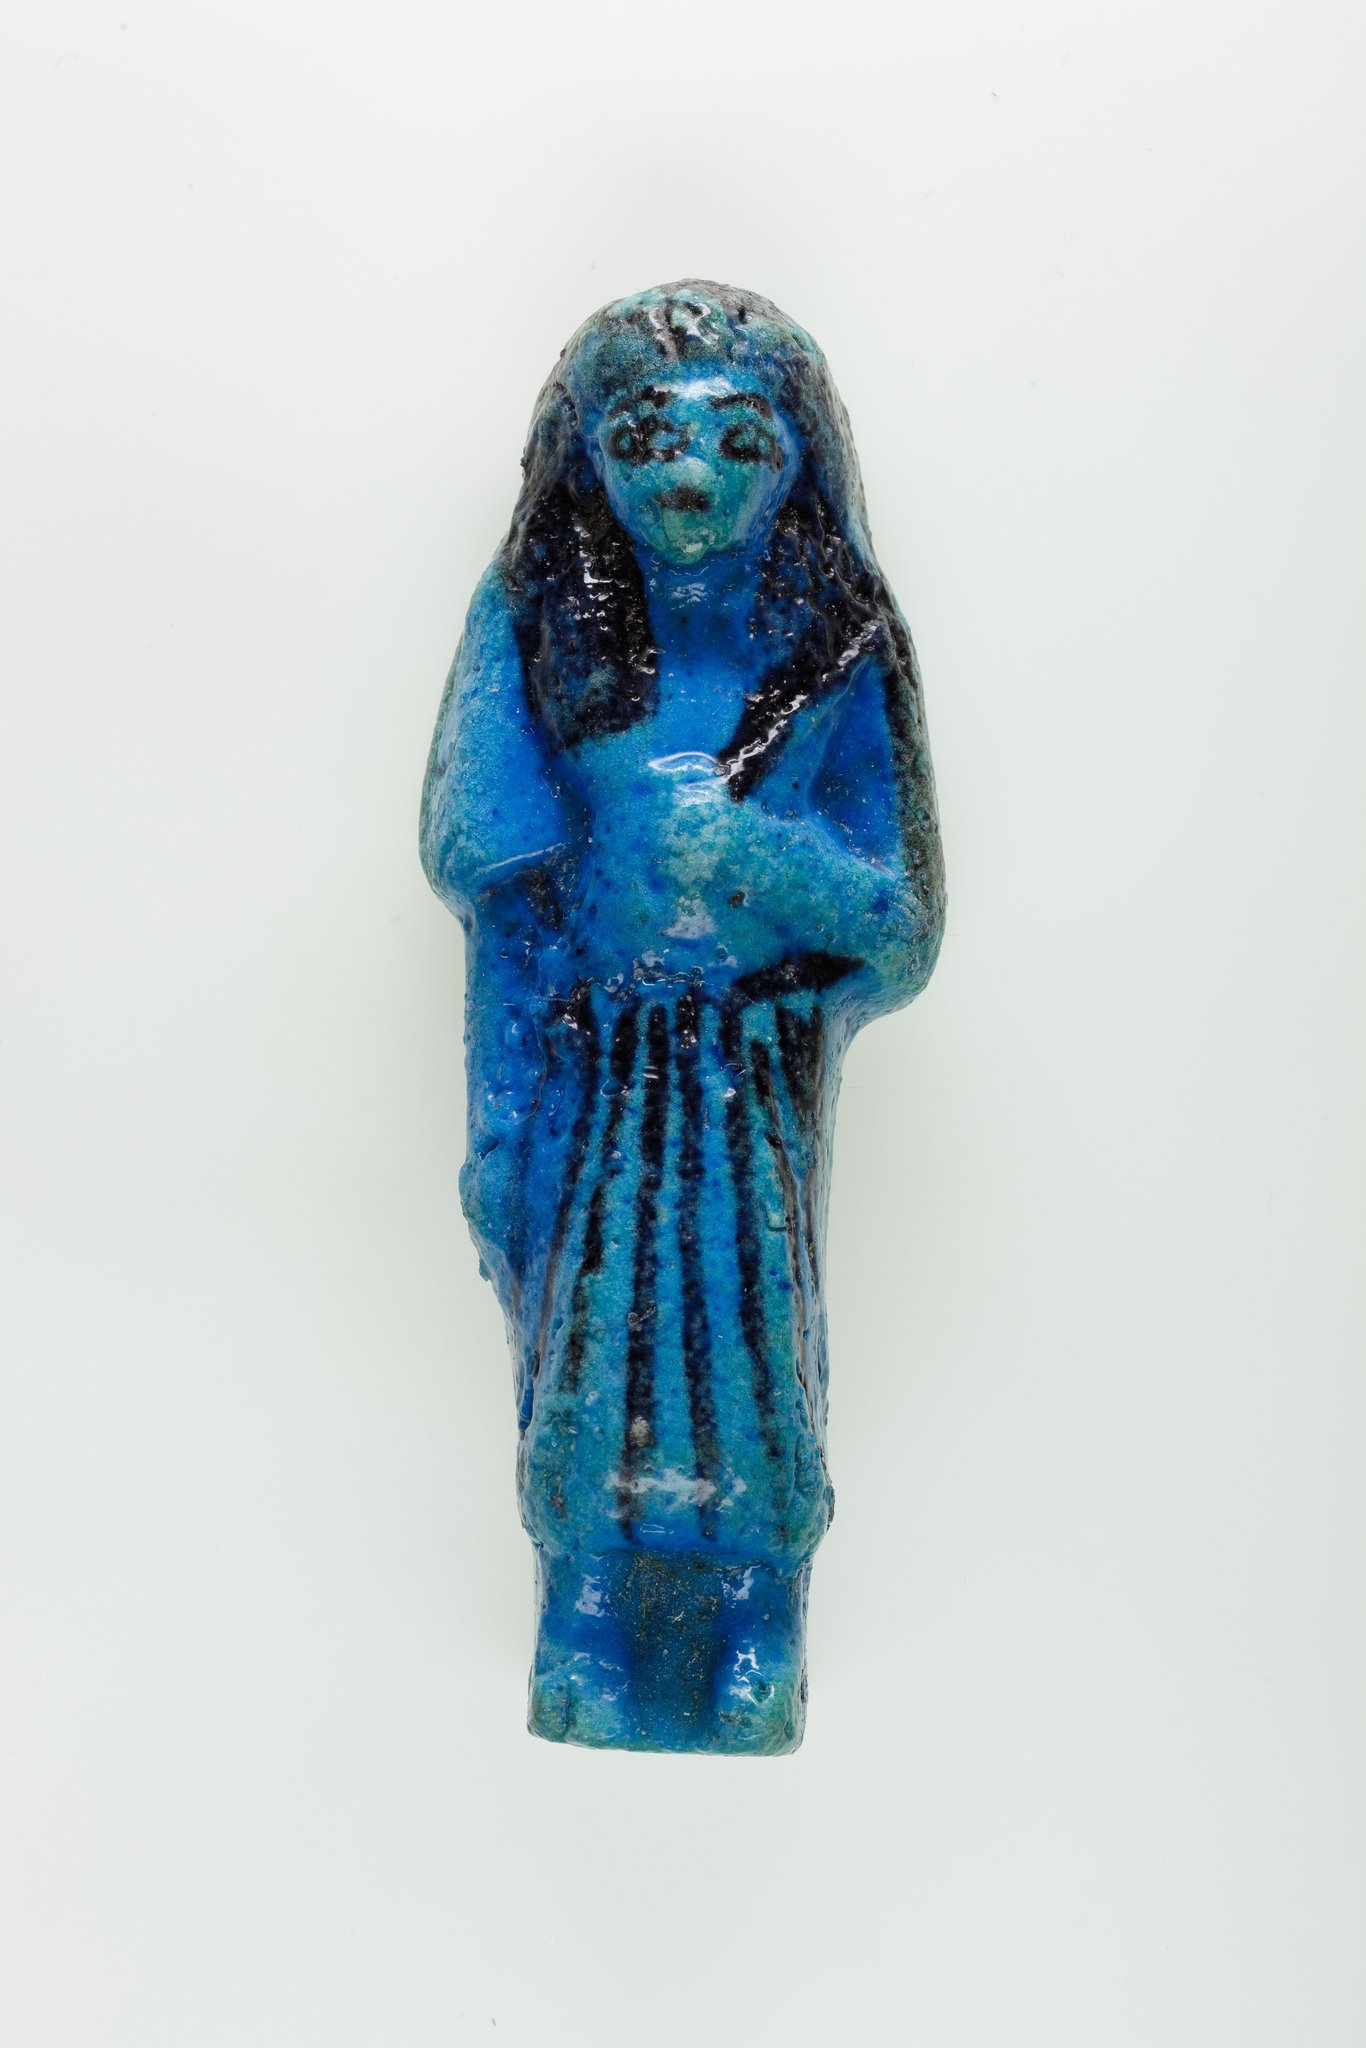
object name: shabti, overseer, nauny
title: Overseer Shabti of Nauny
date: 1050 BCE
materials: faience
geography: egypt